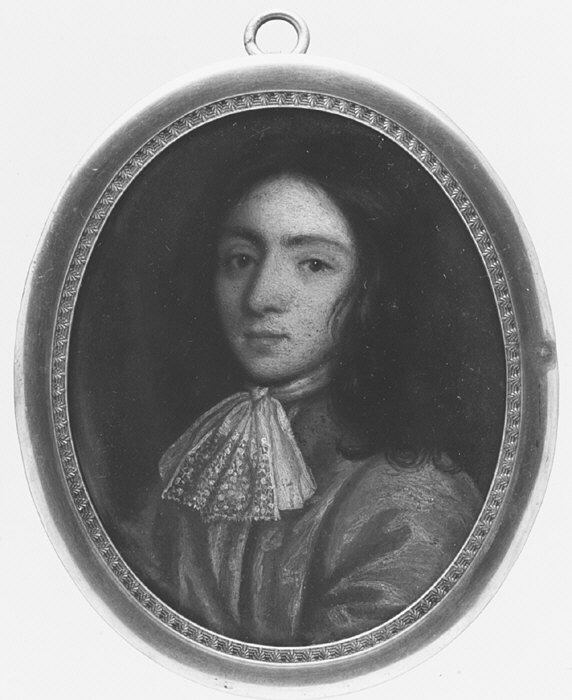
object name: painting, miniature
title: Portrait of a Man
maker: british painter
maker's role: artist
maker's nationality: british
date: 1685-1695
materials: copper, oil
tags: men,portraits